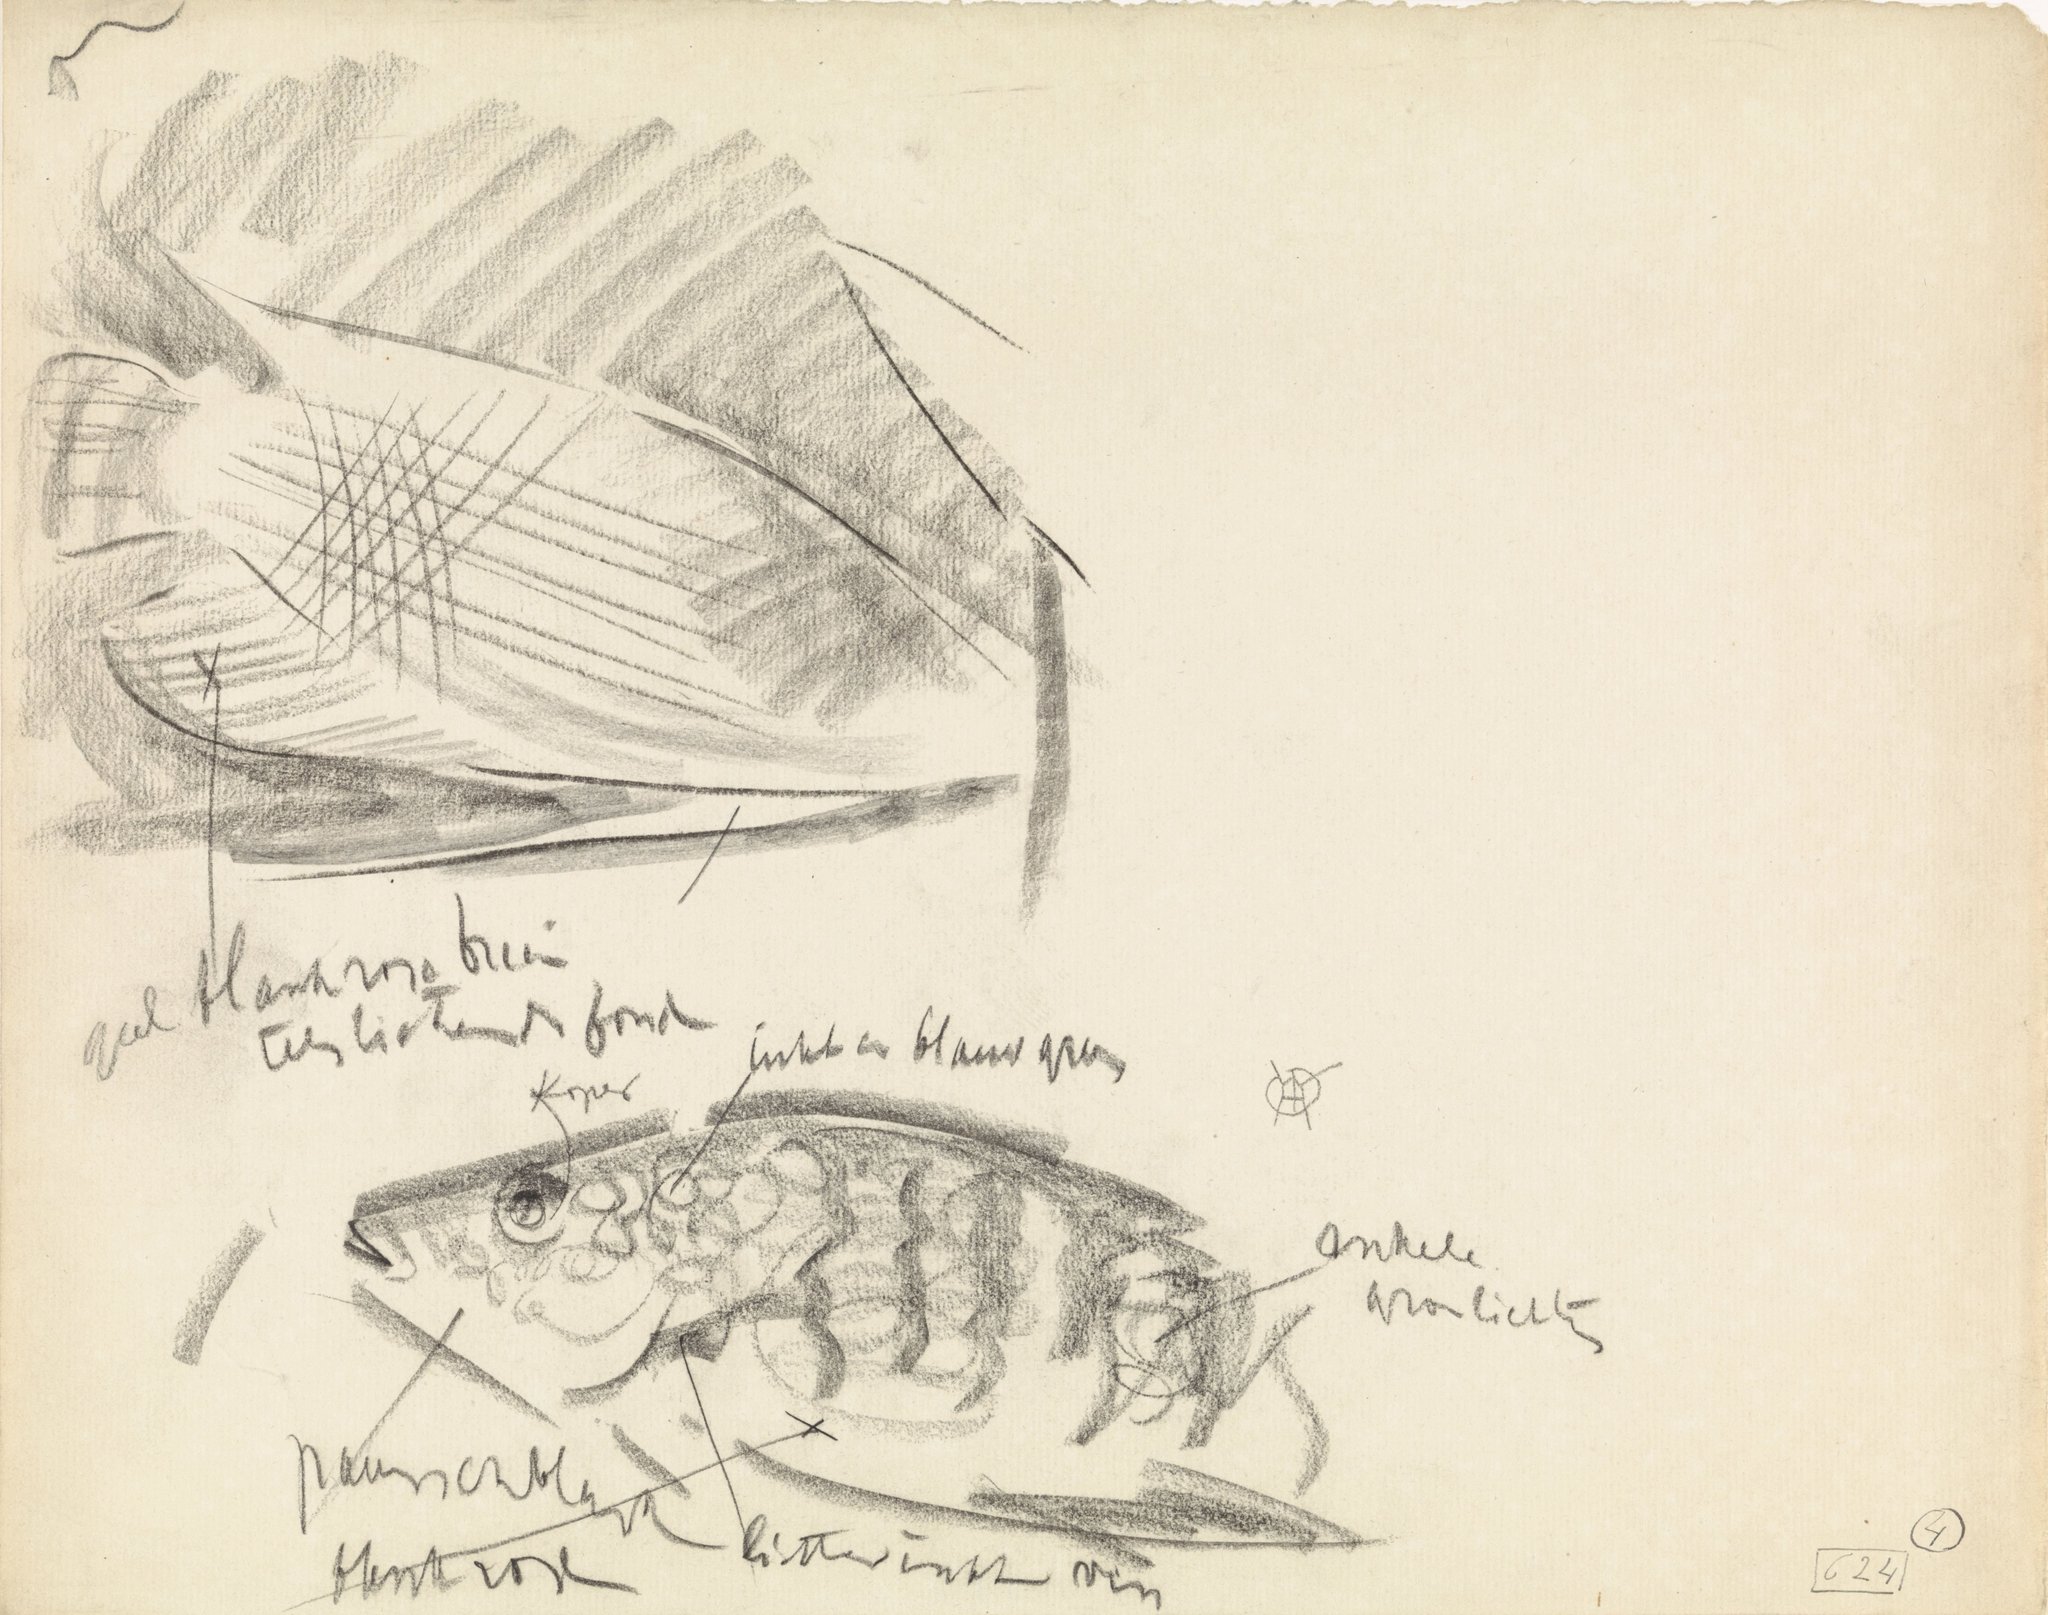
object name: drawing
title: Twee vissen waaronder een Gurami, met kleurnotities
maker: gerrit willem dijsselhof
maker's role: designer, draughtsman, print maker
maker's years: 1866-1924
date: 1876-1924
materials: chalk, paper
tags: bony fishes